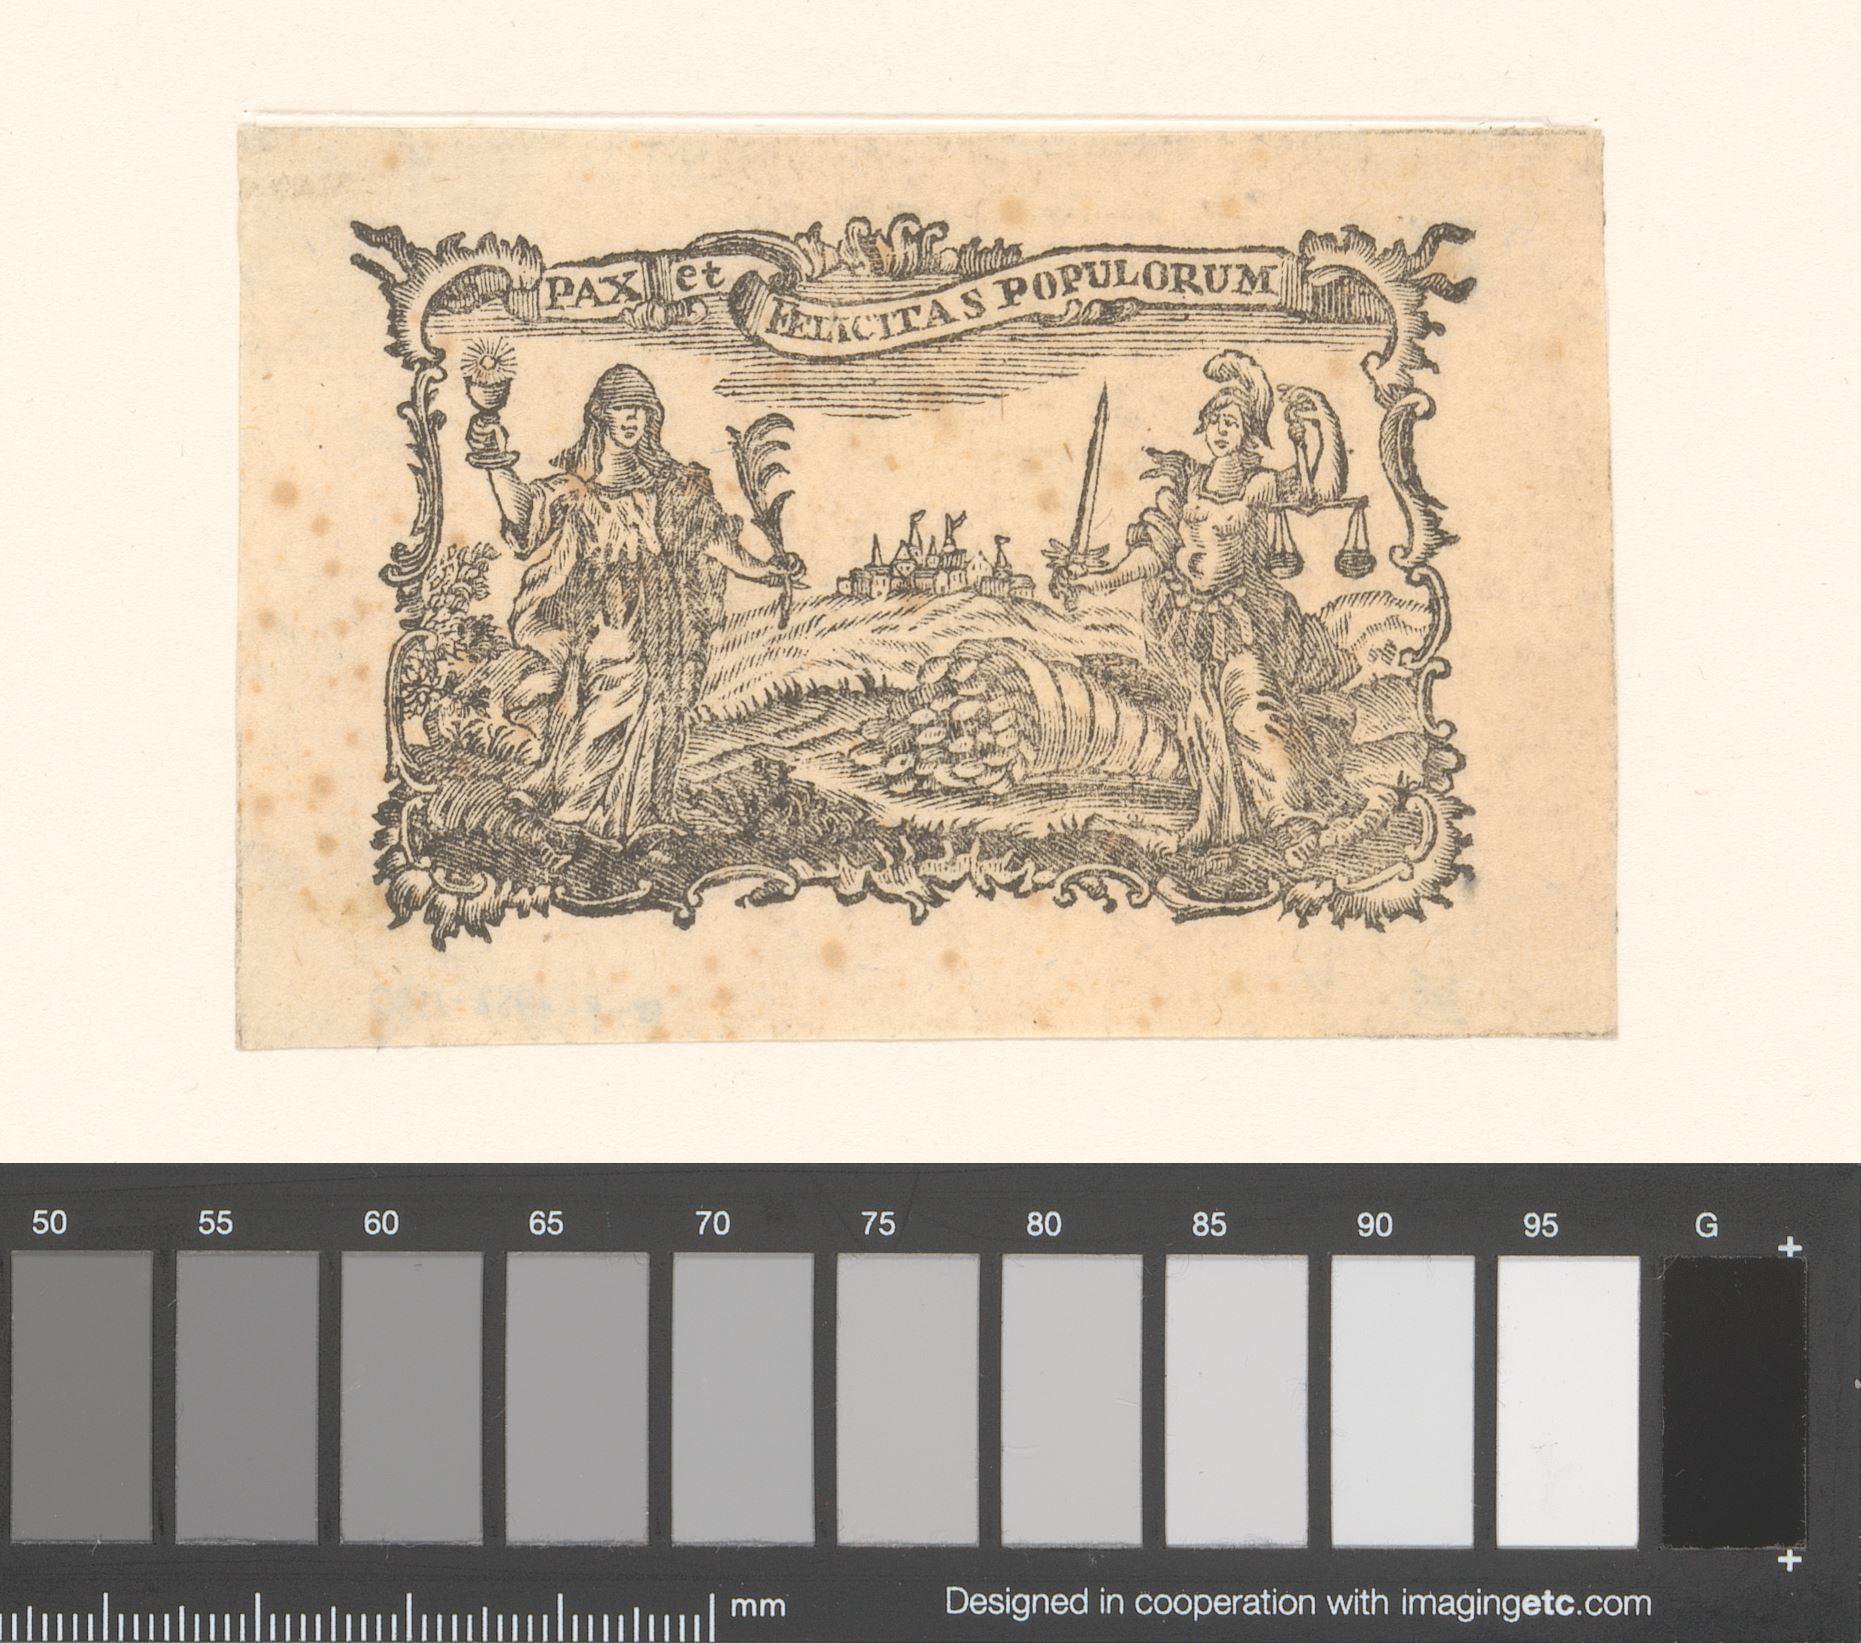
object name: print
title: Pax et Felicitas Populorum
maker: Anonymous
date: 1770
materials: paper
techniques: woodcut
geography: germany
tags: 'cornucopia', horn of plenty, justitia (justice) as roman personification, pax as roman personification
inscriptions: collector's mark: Lugt 2760, collector's mark: Lugt 2228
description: Drukkersmerk gebruikt in: Hontheim, Johann Nikolaus von. De Statu Ecclesiae et Legitima Potestate Romani Pontificis. Frankfurt en Leipzig: s.n., 1770. Waarschijnlijk ook gebruikt in andere publicaties.